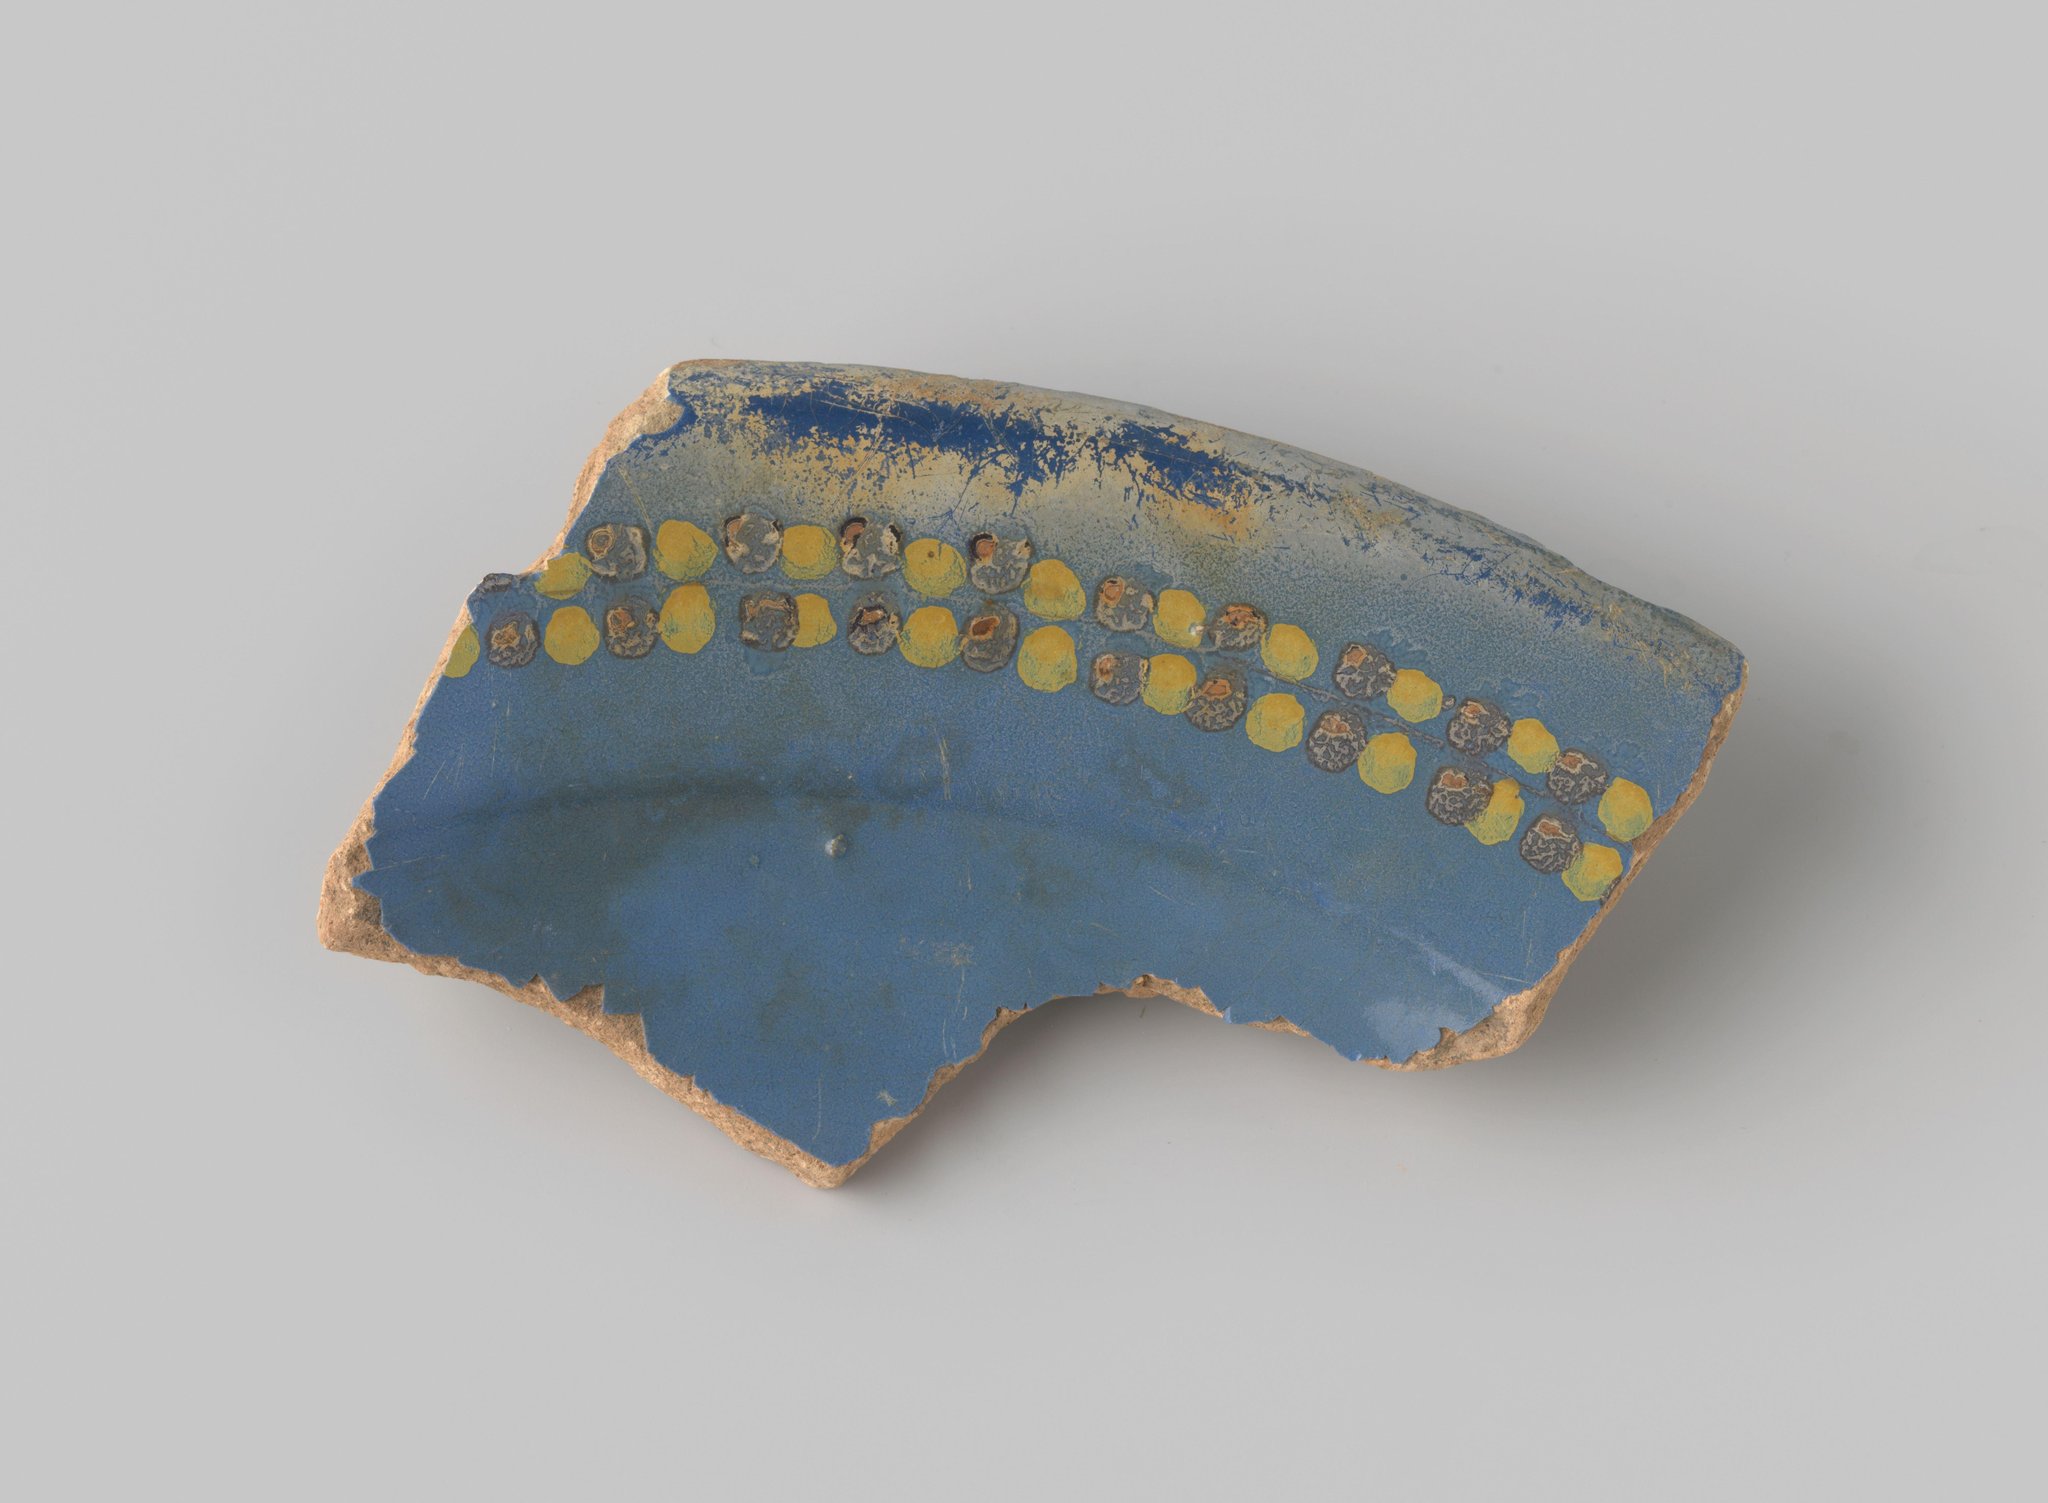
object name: fragment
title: Scherf van rossigbakkend aardewerk, aan de voorzijde voorzien van blauw glazuur, met daarop aan weerszijden van een streep gele en oranje stippen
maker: Anonymous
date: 1600-1650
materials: earthenware, glaze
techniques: maiolica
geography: northern netherlands